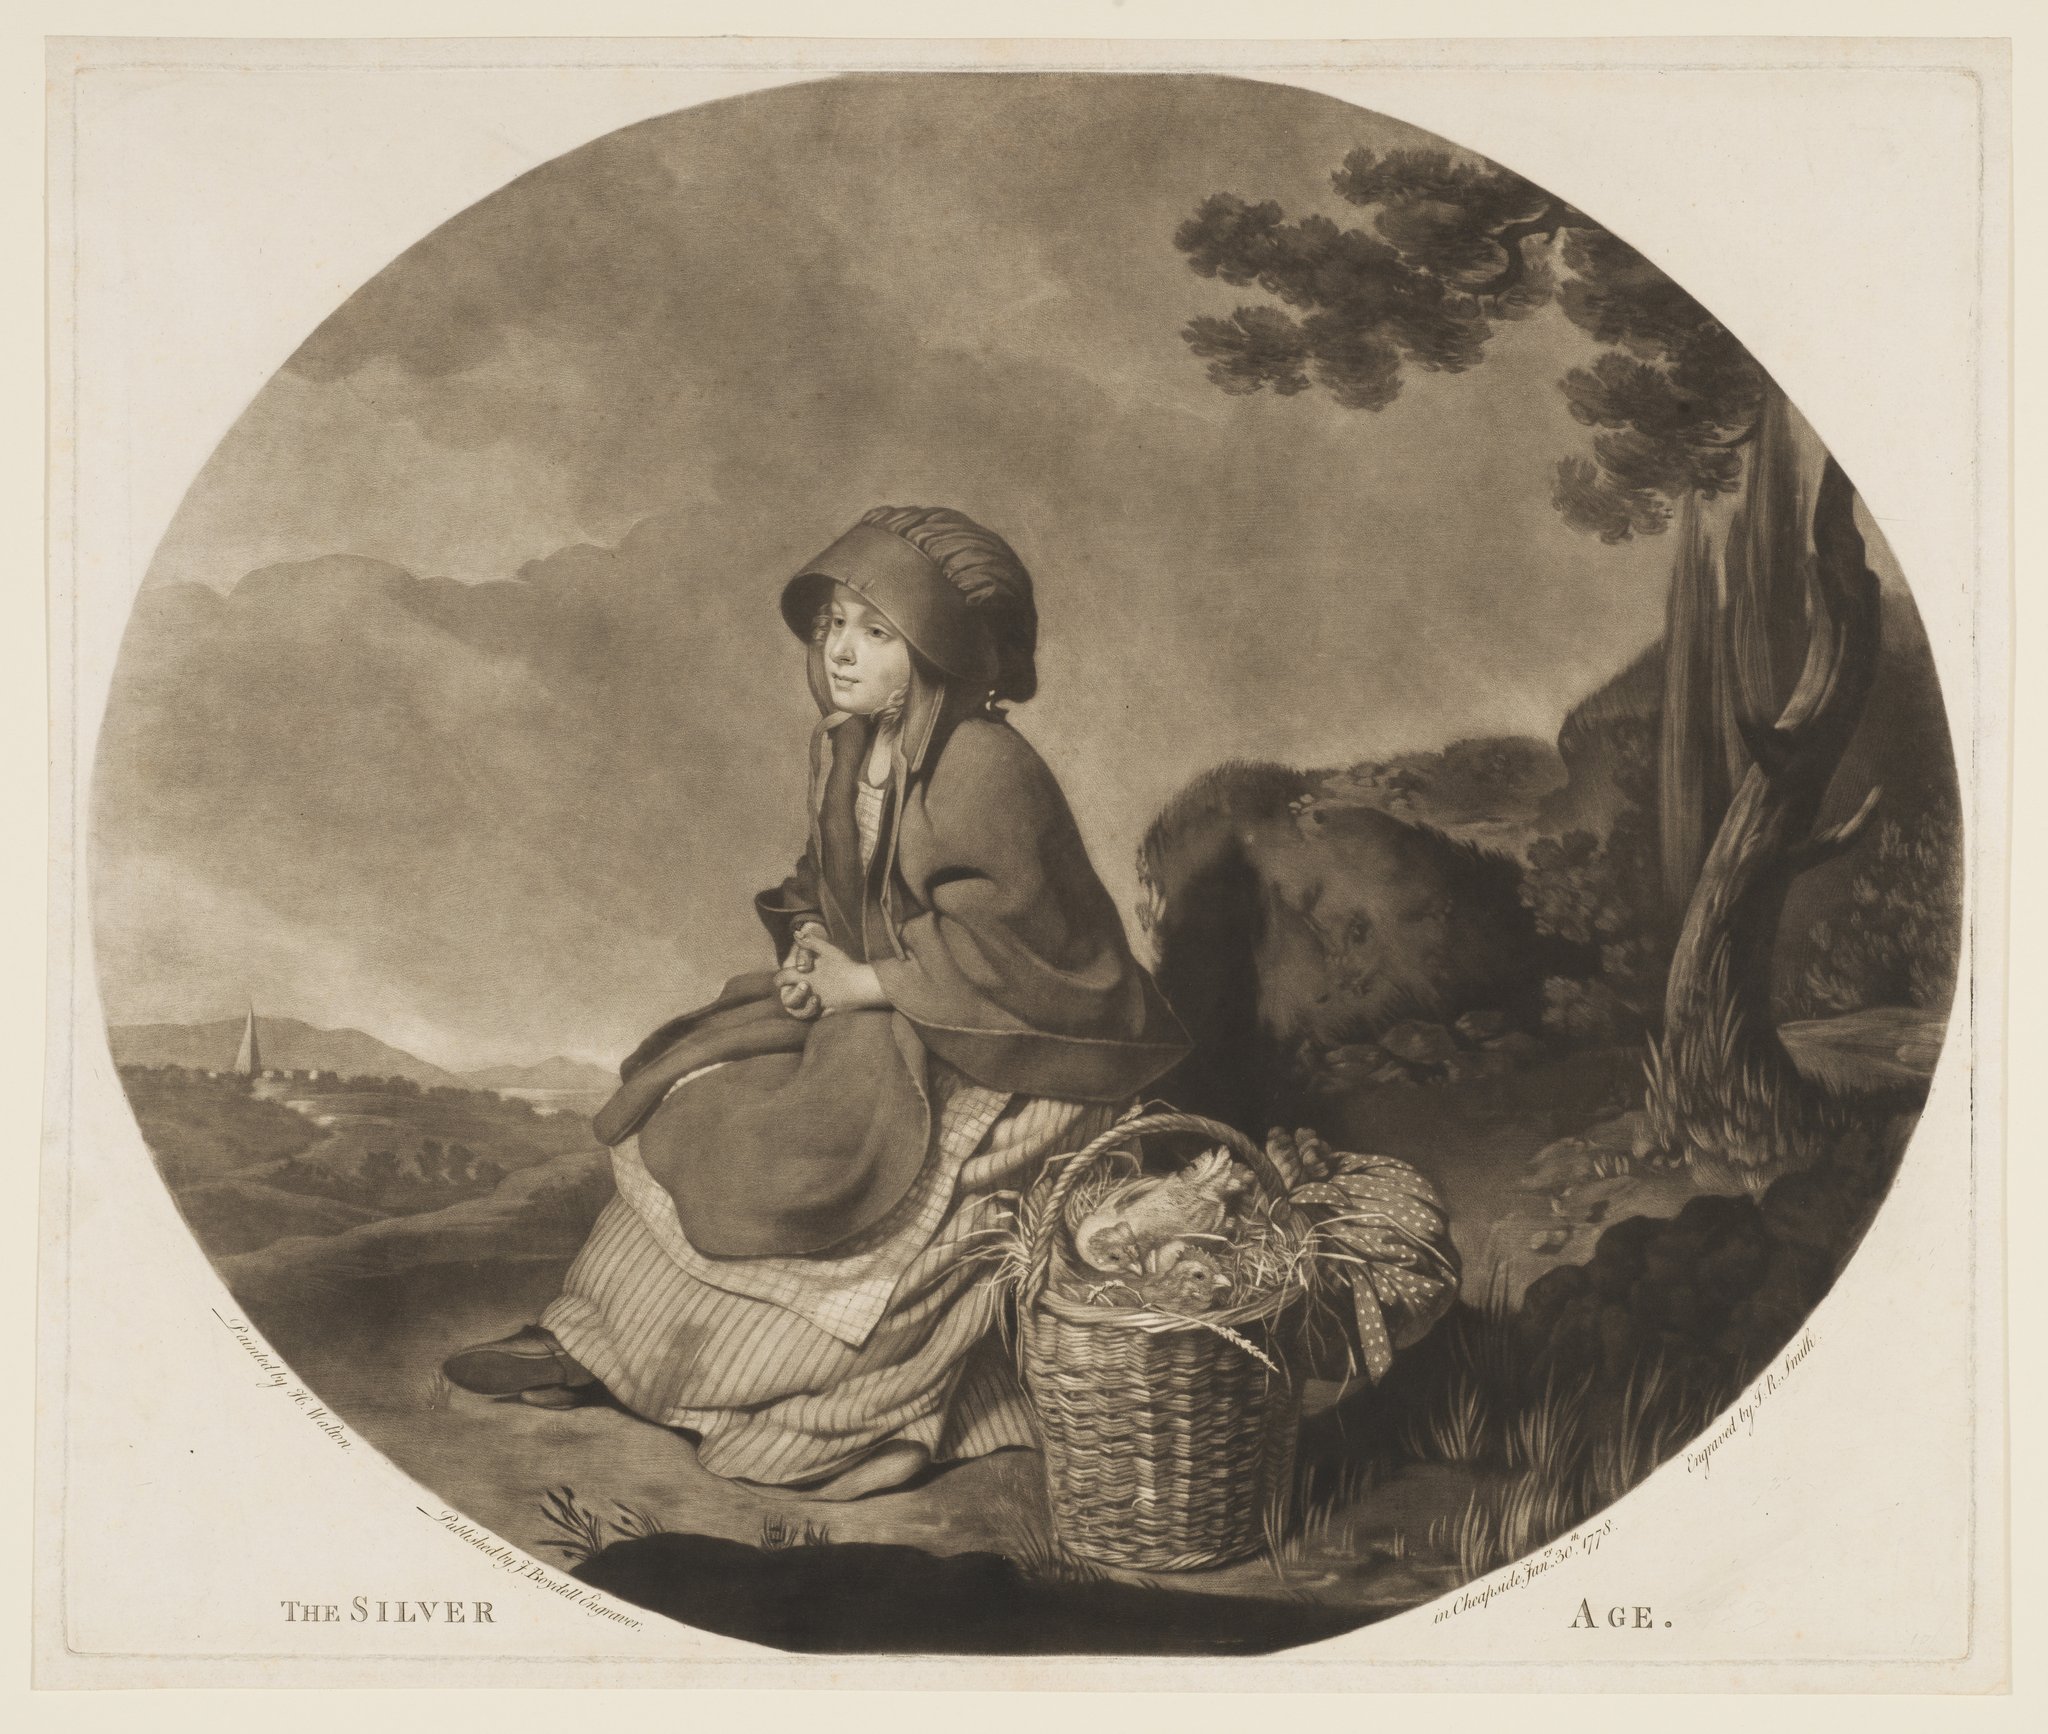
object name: print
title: The Sliver Age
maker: john raphael smith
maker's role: engraver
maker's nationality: british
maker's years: 1751-1812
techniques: mezzotint